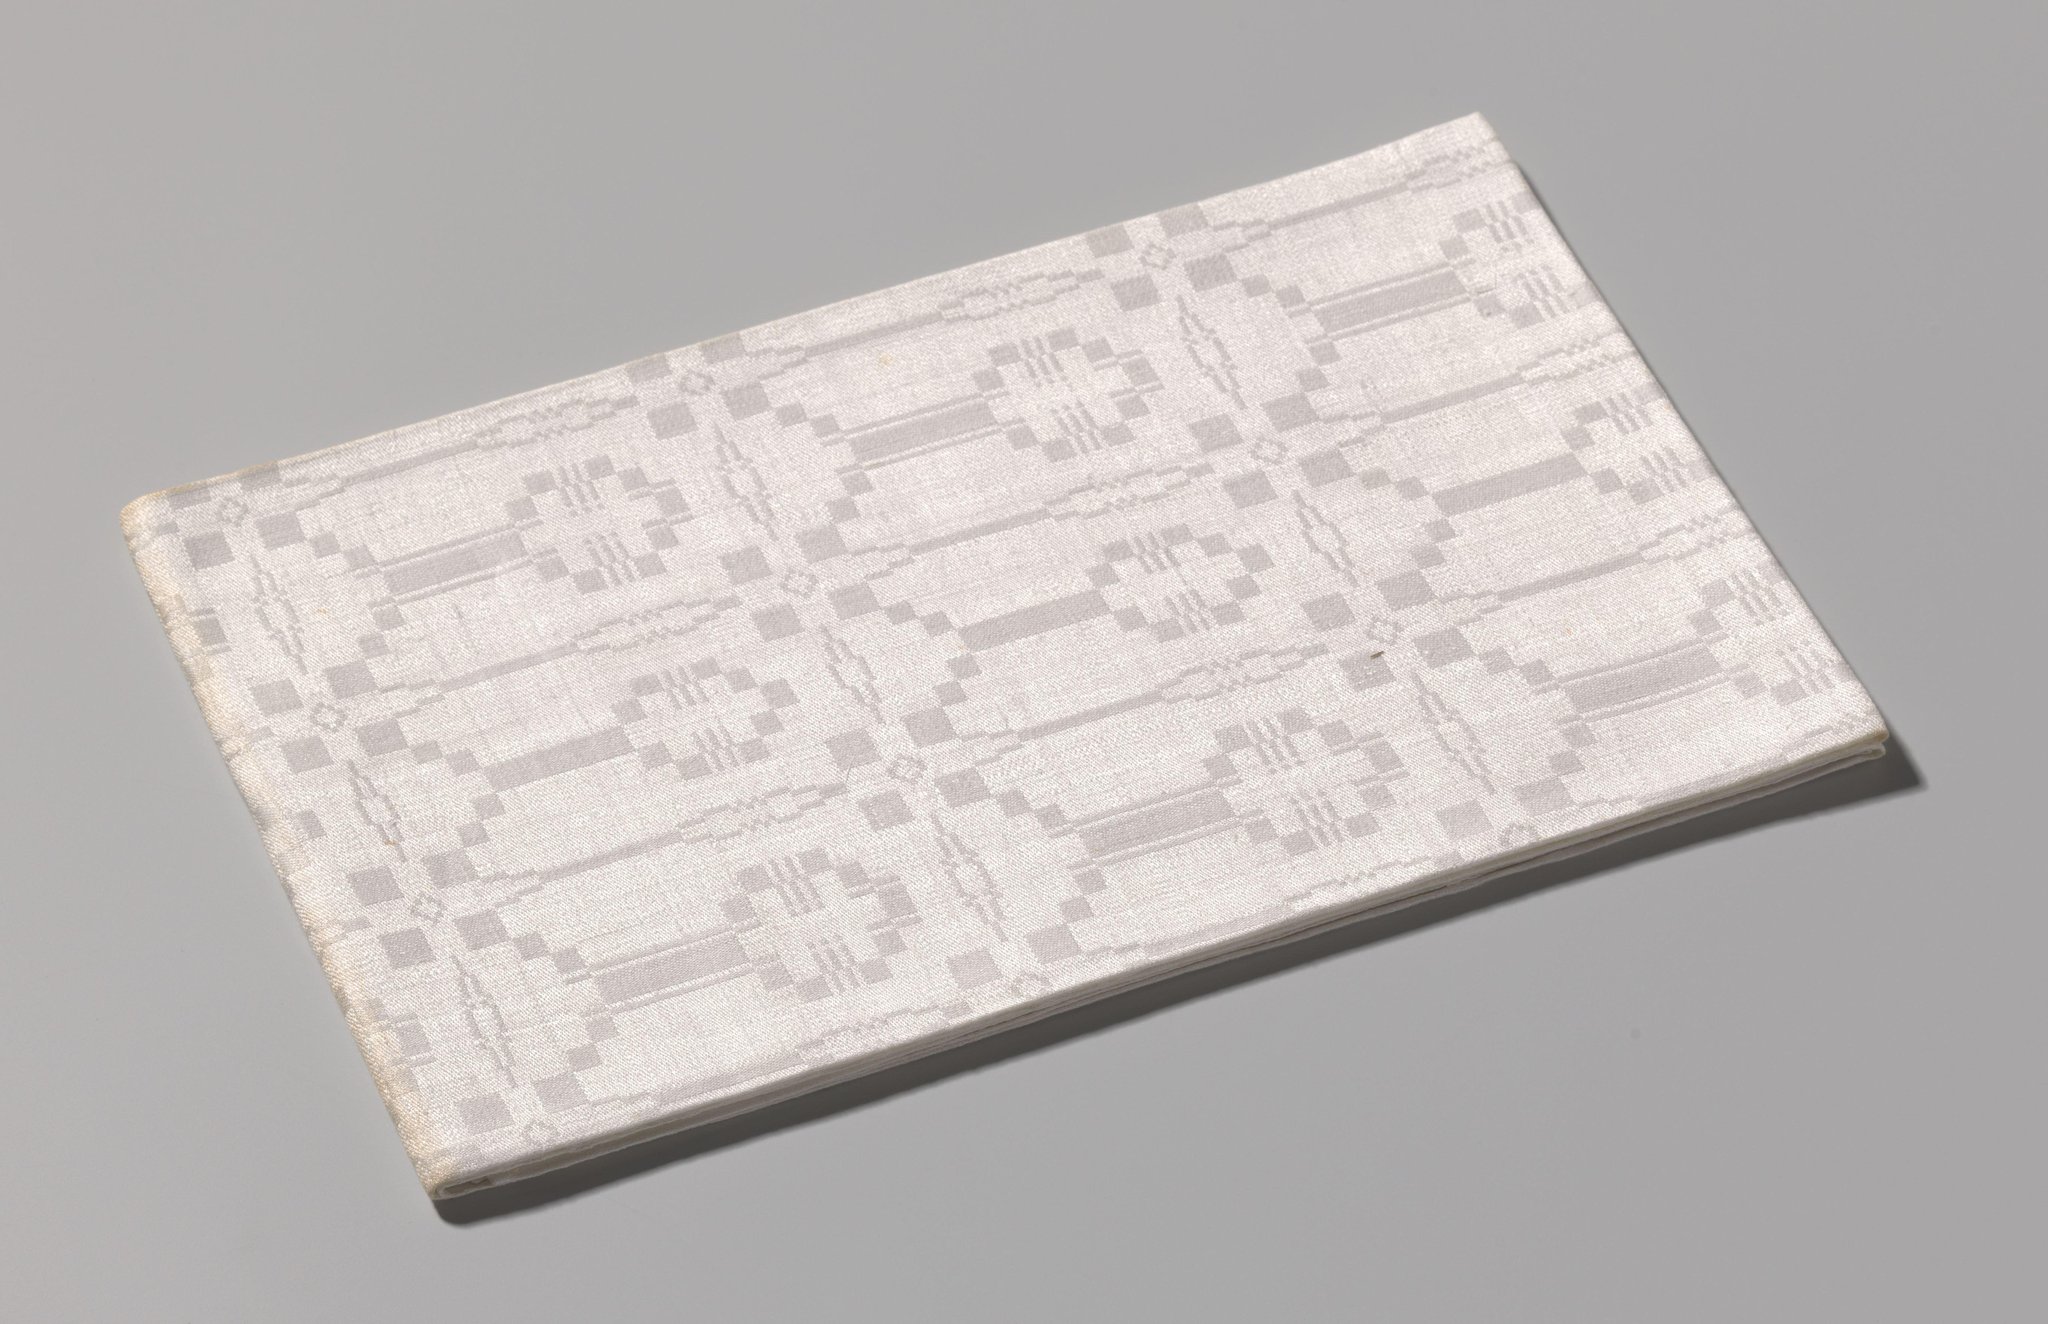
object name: napkin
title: Servet van linnen met pellenpatroon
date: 1726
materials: linen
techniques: peeled fabric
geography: northern netherlands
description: wit linnen servet met pellen patroon, merk GS 60 en 1726